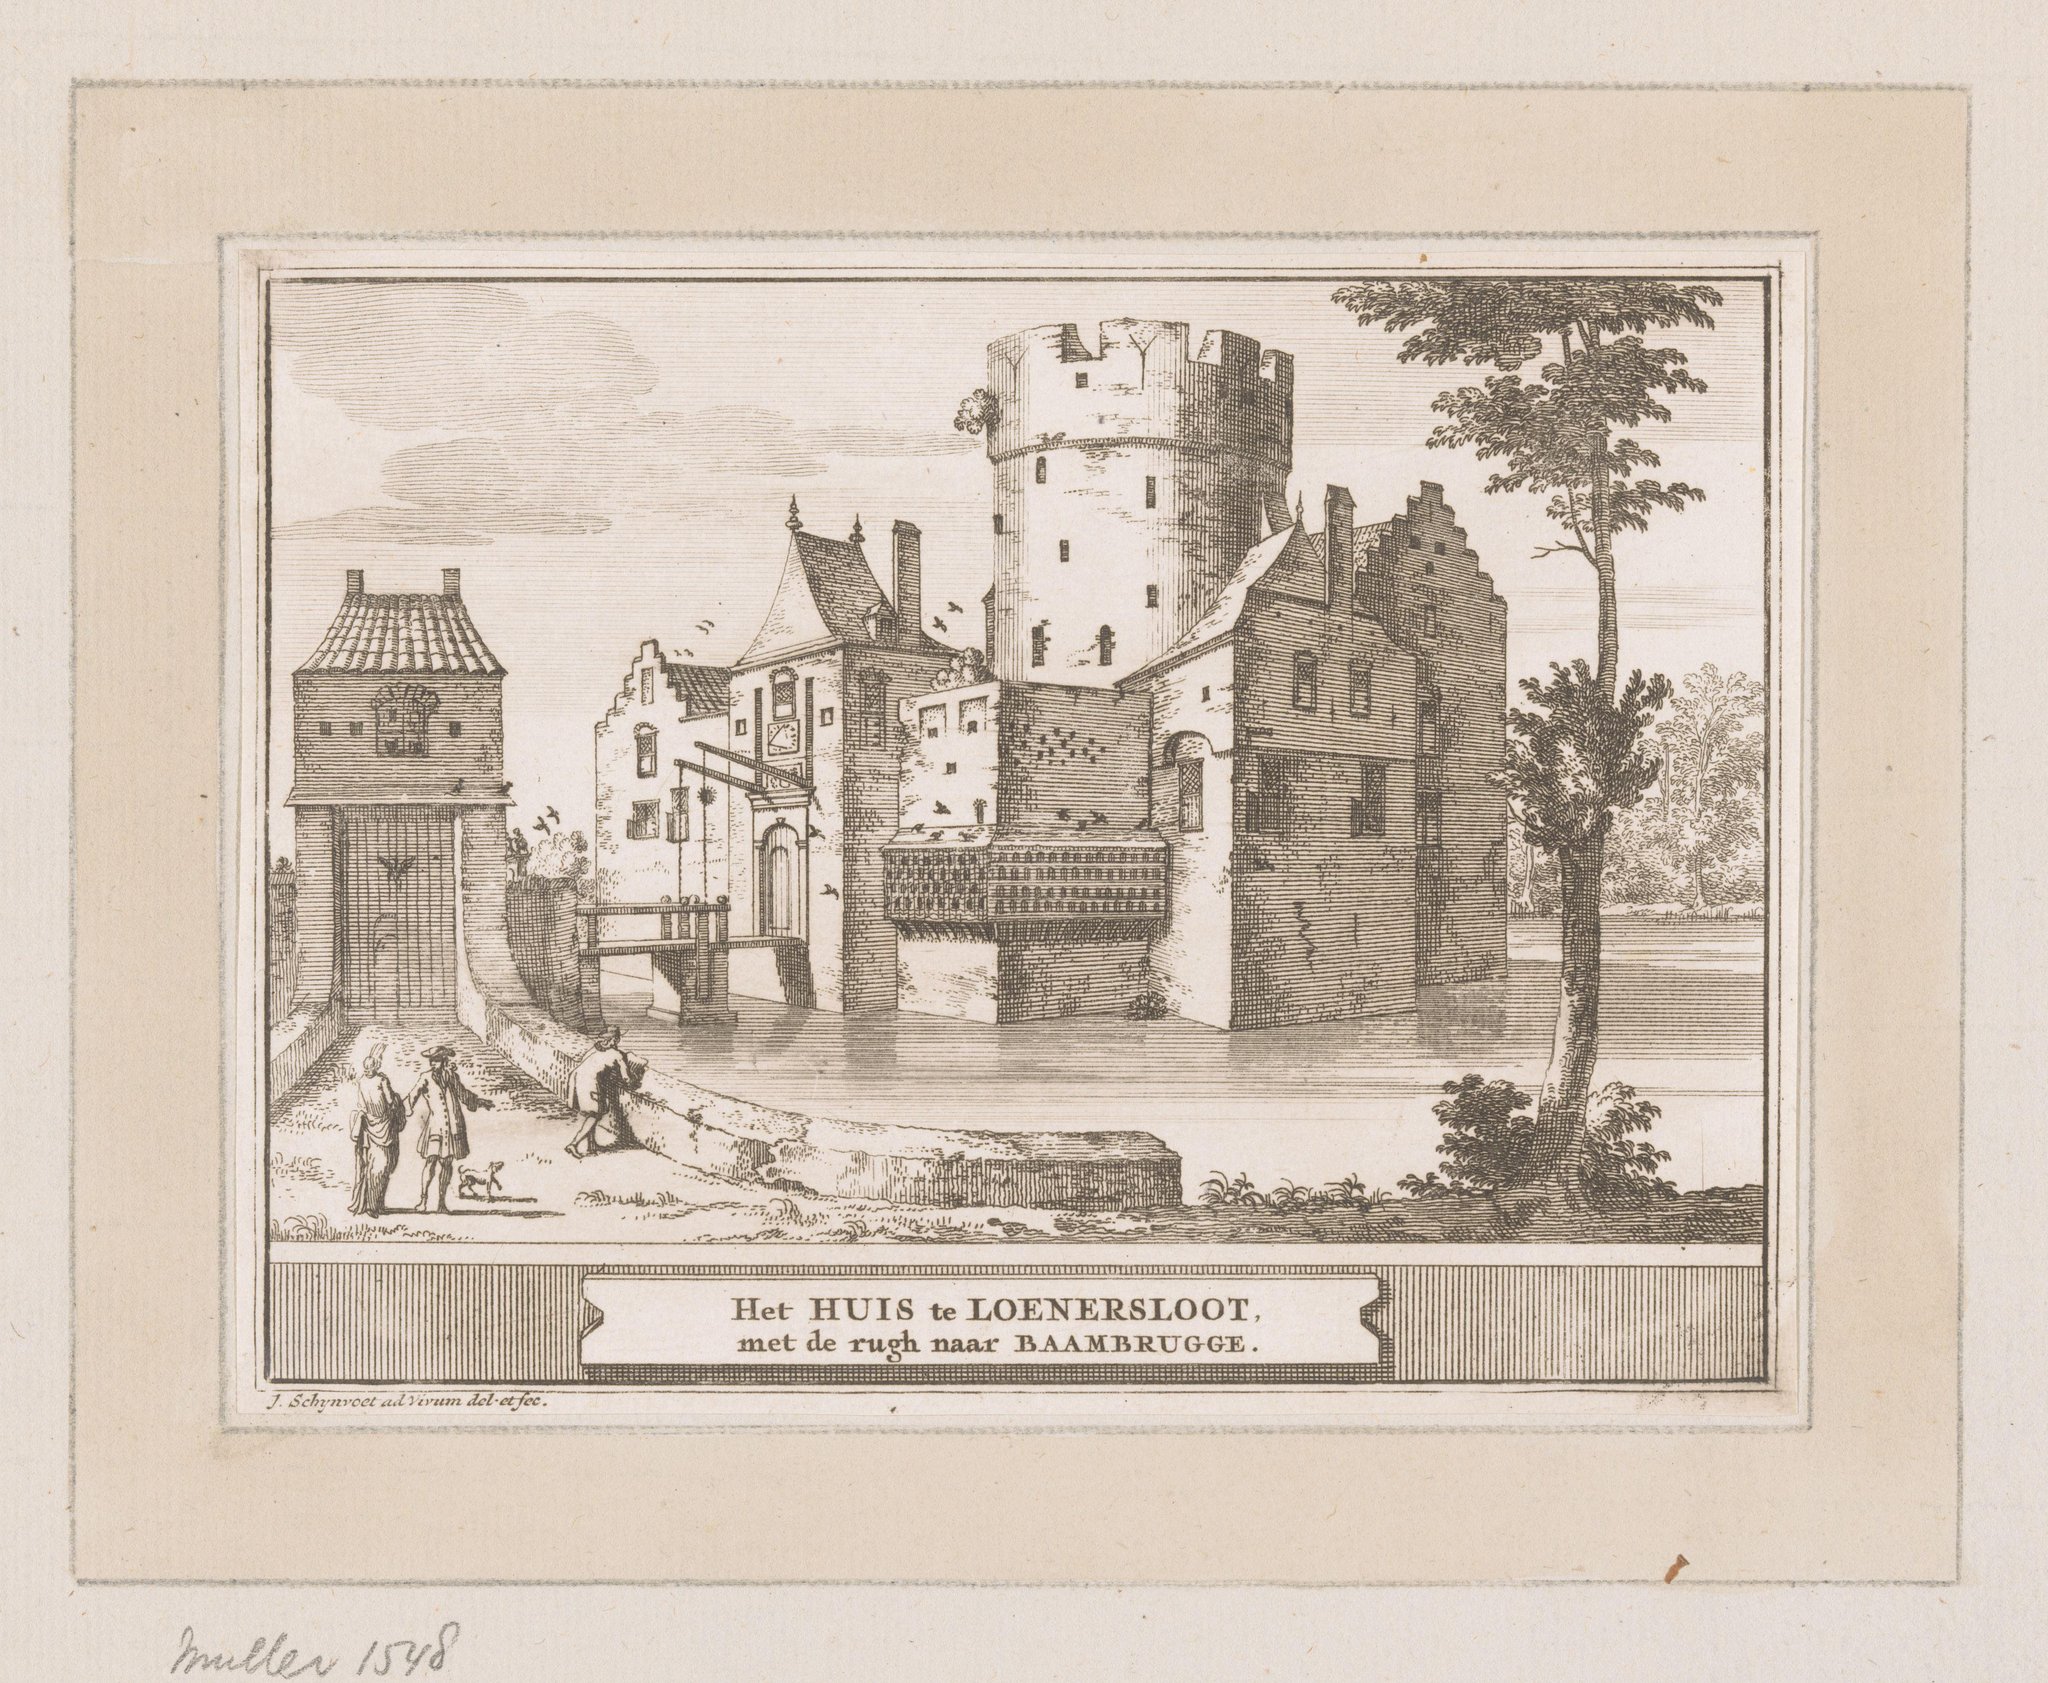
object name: print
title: Kastelen in Nederland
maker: jacobus schijnvoet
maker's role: draughtsman, print maker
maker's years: 1685-1743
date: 1711-1774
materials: paper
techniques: etching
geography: amsterdam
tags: castle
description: Prent opgenomen in: Smids, Ludolph. Schatkamer der Nederlandsse[!] oudheden; of Woordenboek, behelsende Nederlands steden, Amsterdam: Pieter de Coup, 1711. Verscheen tevens in de heruitgave van voorgenoemd werk in 1737 en 1774. In 1721 verscheen er een uitgave met alleen de prenten: Nederlandsche oudheden, bestaande in zestig verbeeldingen (...) gelegen in Holland, 't Sticht van Utrecht en Gelderland enz. Amsterdam: Hendrik Bosch, 1721.